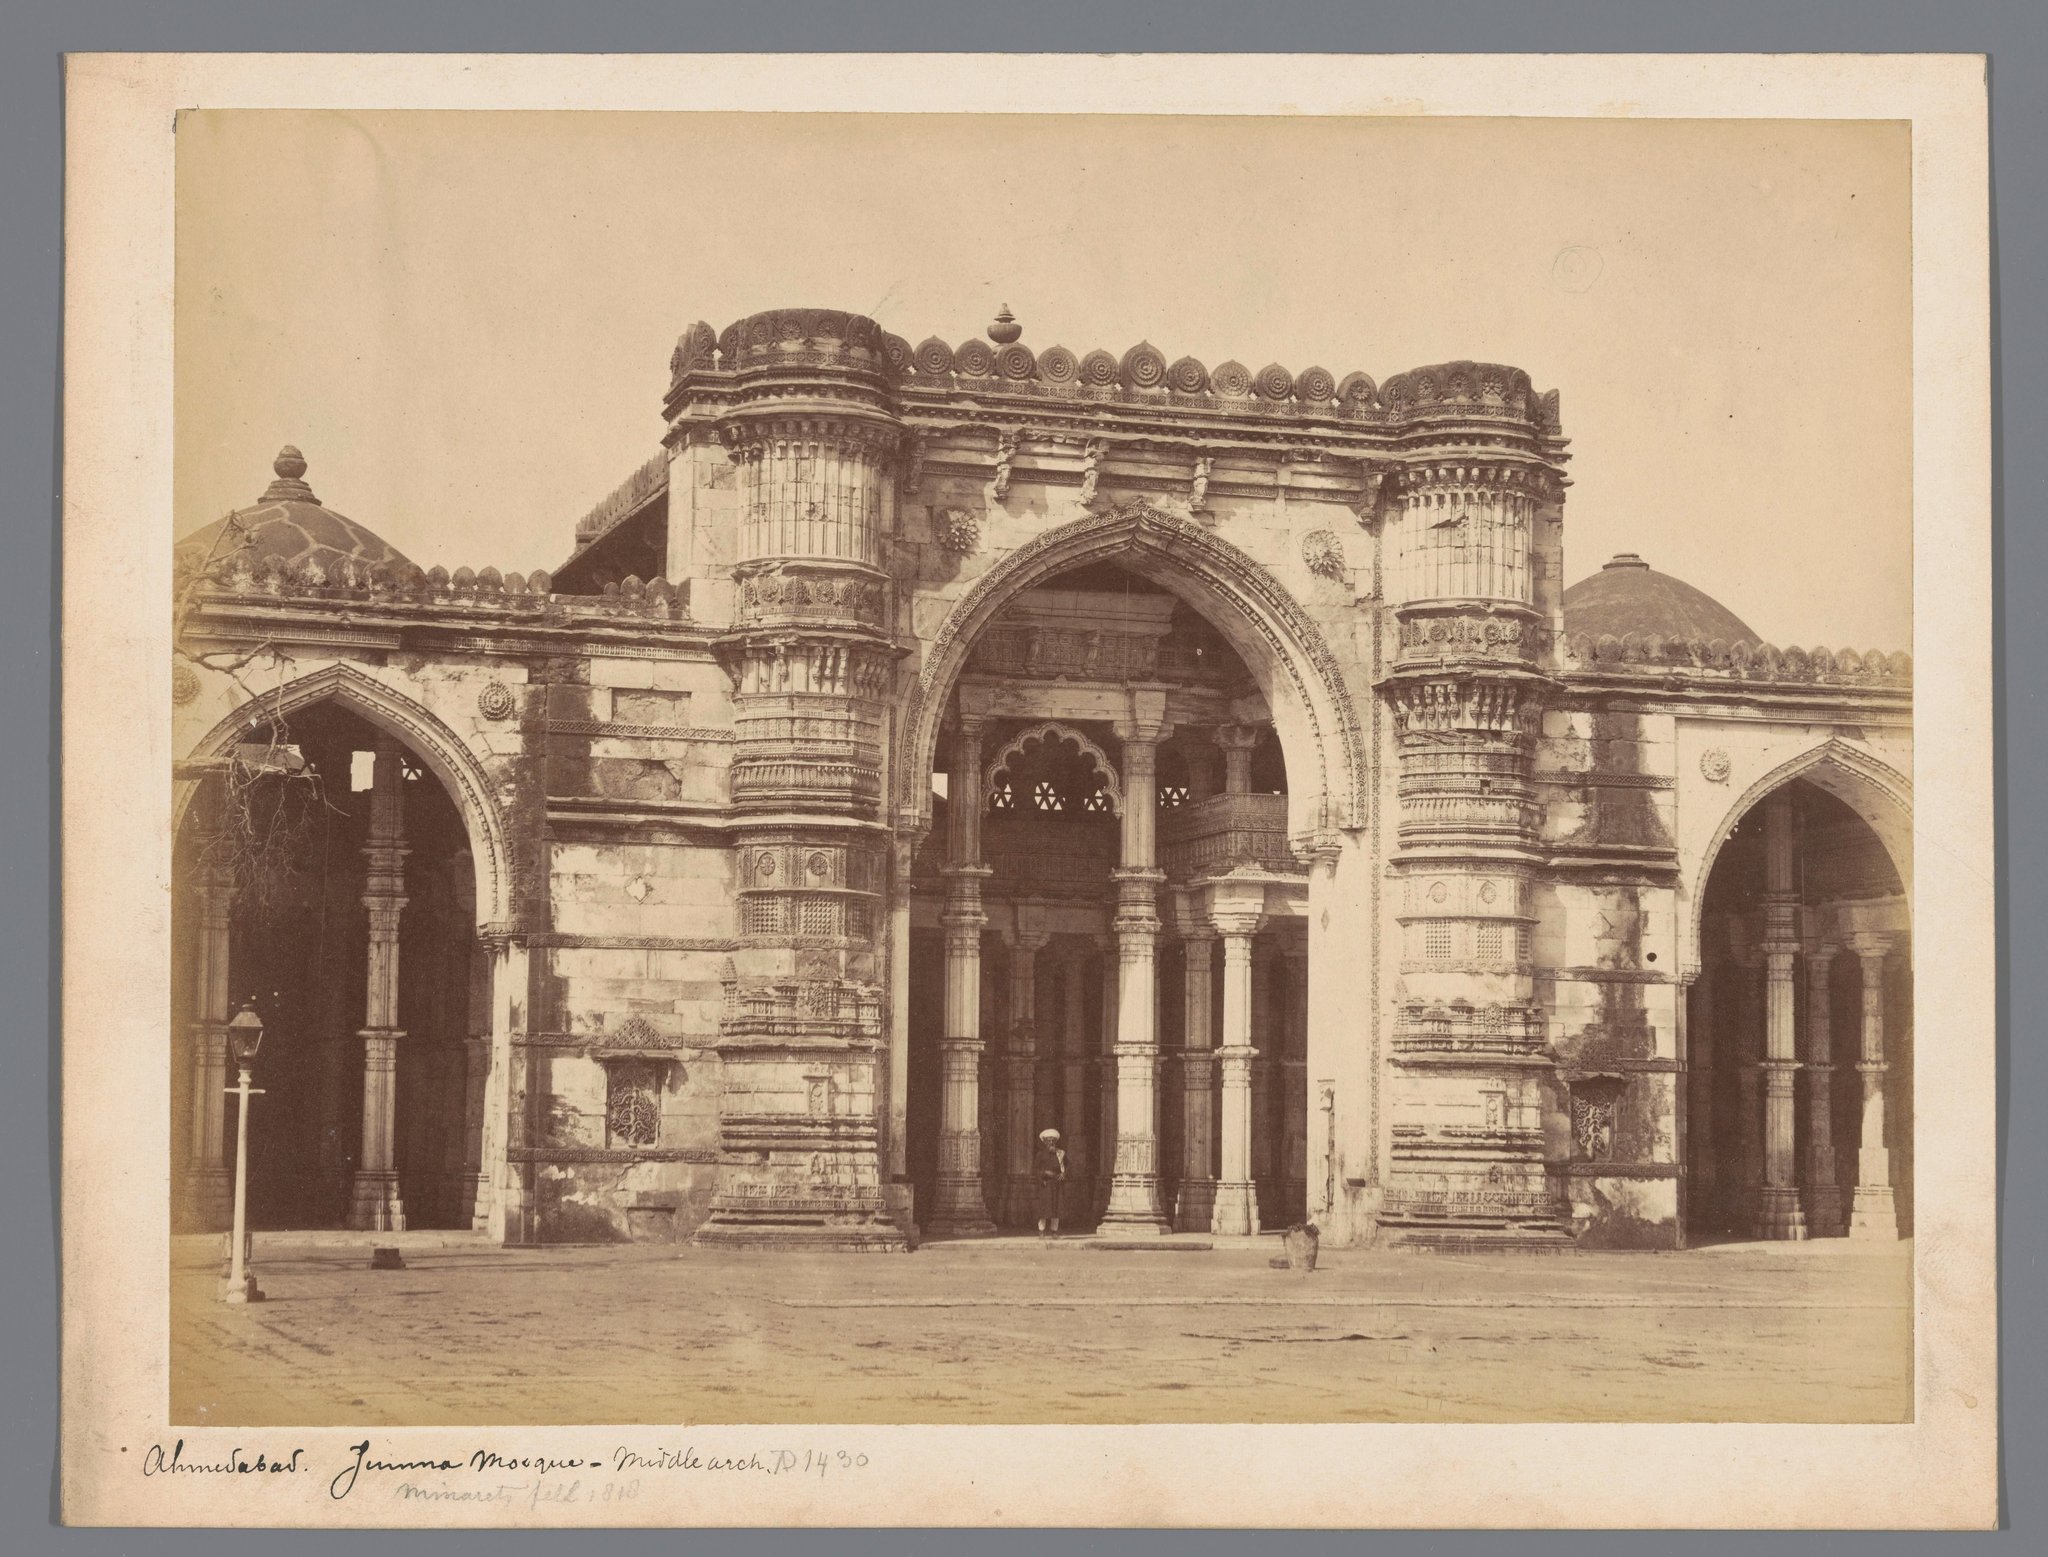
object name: photograph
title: Exterior of the Jama mosque in Ahmedebad, Gujarat, India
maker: Anonymous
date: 1865-1890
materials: cardboard, paper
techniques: albumen print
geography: ahmedabad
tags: temple, shrine ~ islam, mohammedanism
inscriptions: title: ‘Ahmedebad. Jumma Mosque - Middle arch. AD 1430’, inscription: ‘minarets fell 1818’, number: ‘21’